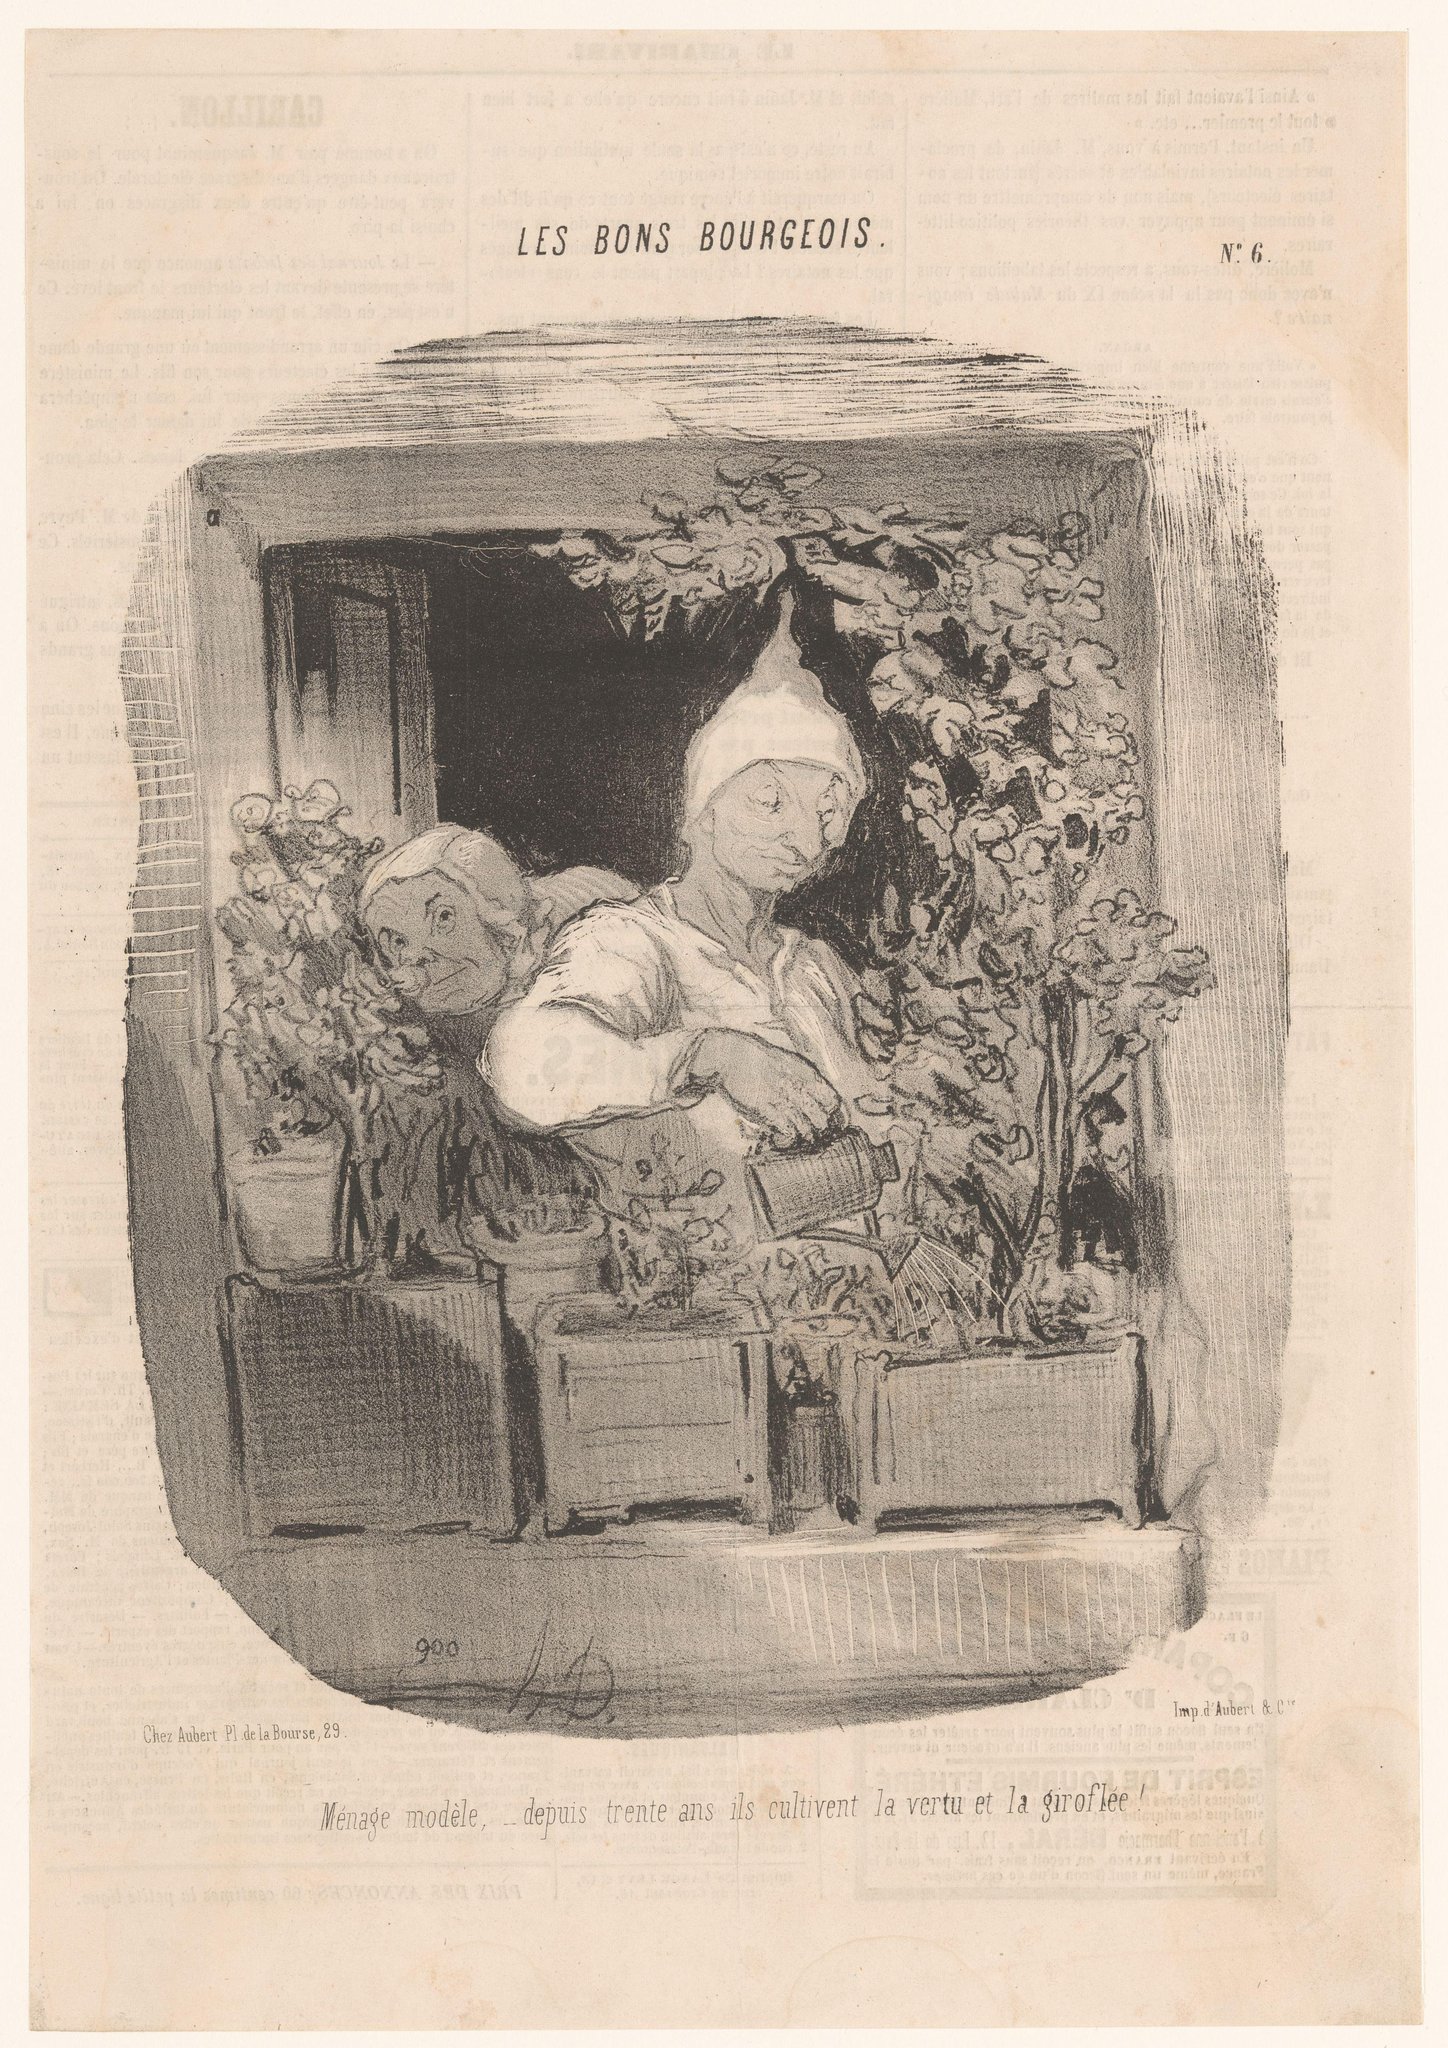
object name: cartoon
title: Goede burgers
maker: honoré daumier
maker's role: draughtsman, painter, print maker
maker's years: 1808-1879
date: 1846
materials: paper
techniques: lithograph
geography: paris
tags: caricatures (human types), open window, satire on marriage, potted plants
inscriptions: collector's mark: Lugt 2228a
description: Prent gebruikt voor: Le Charivari, 10-07-1846.